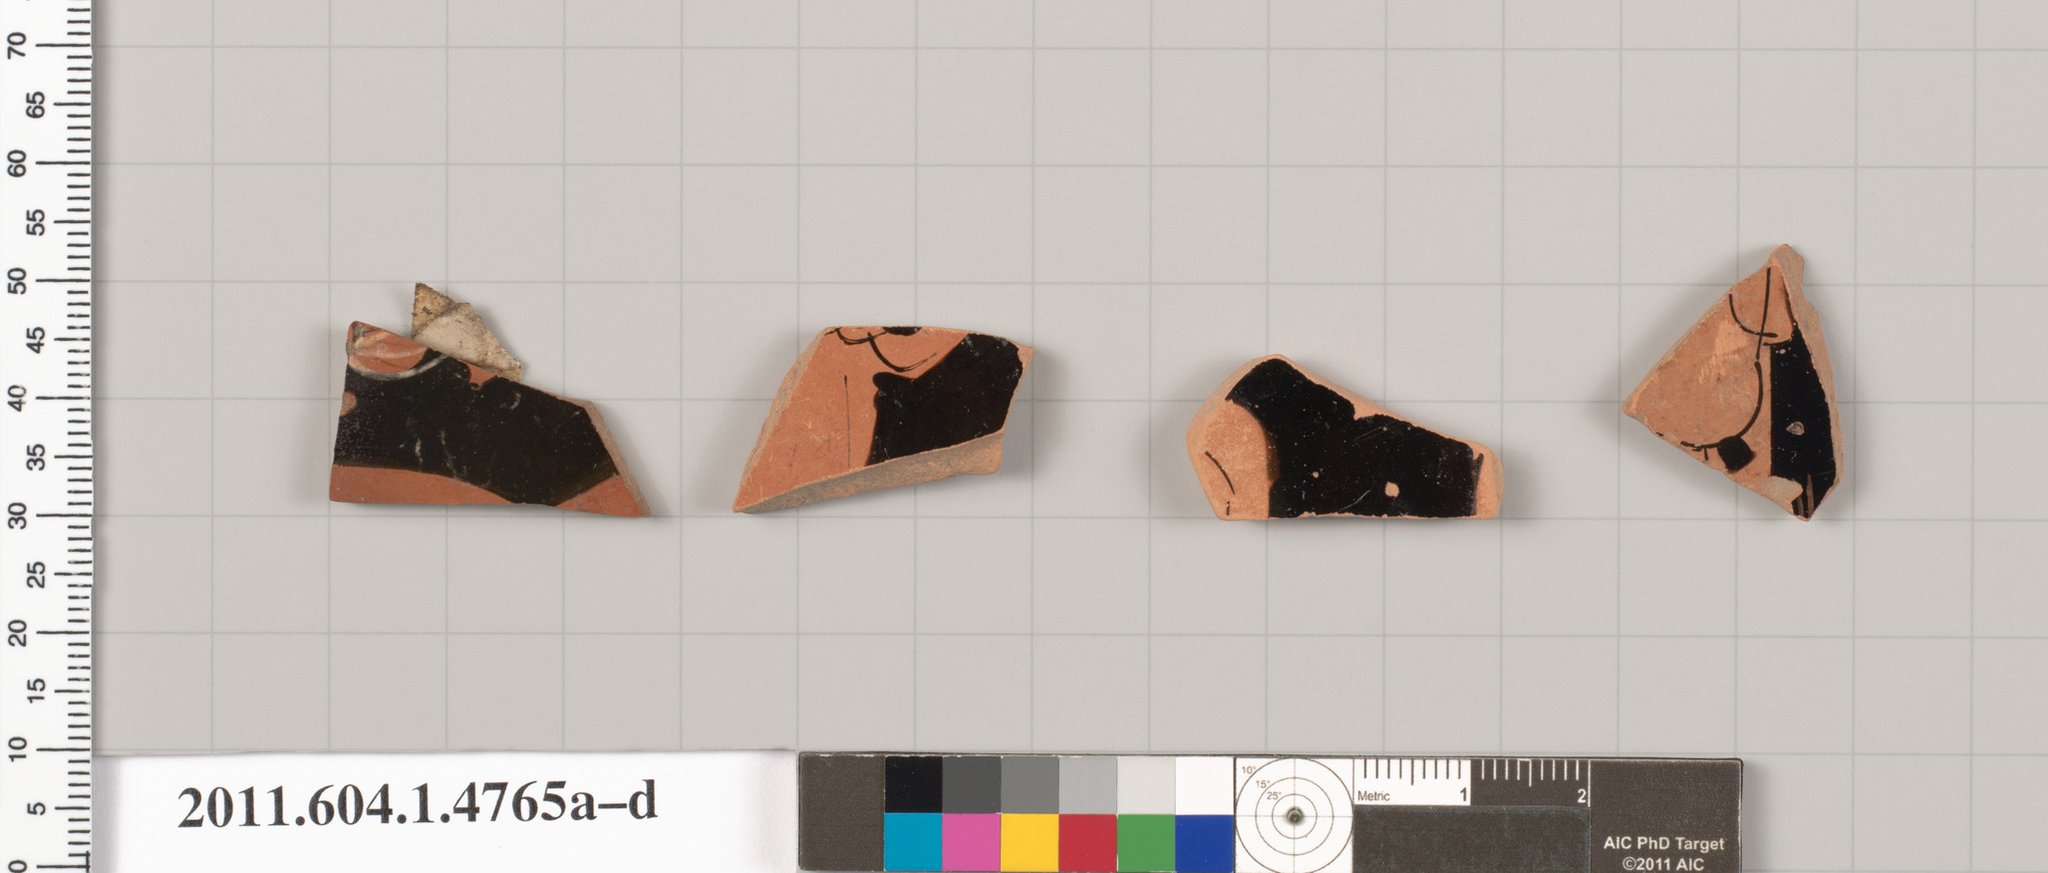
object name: kylix fragment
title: Terracotta fragments of kylikes (drinking cups)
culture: greek, attic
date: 475-451 BCE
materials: terracotta